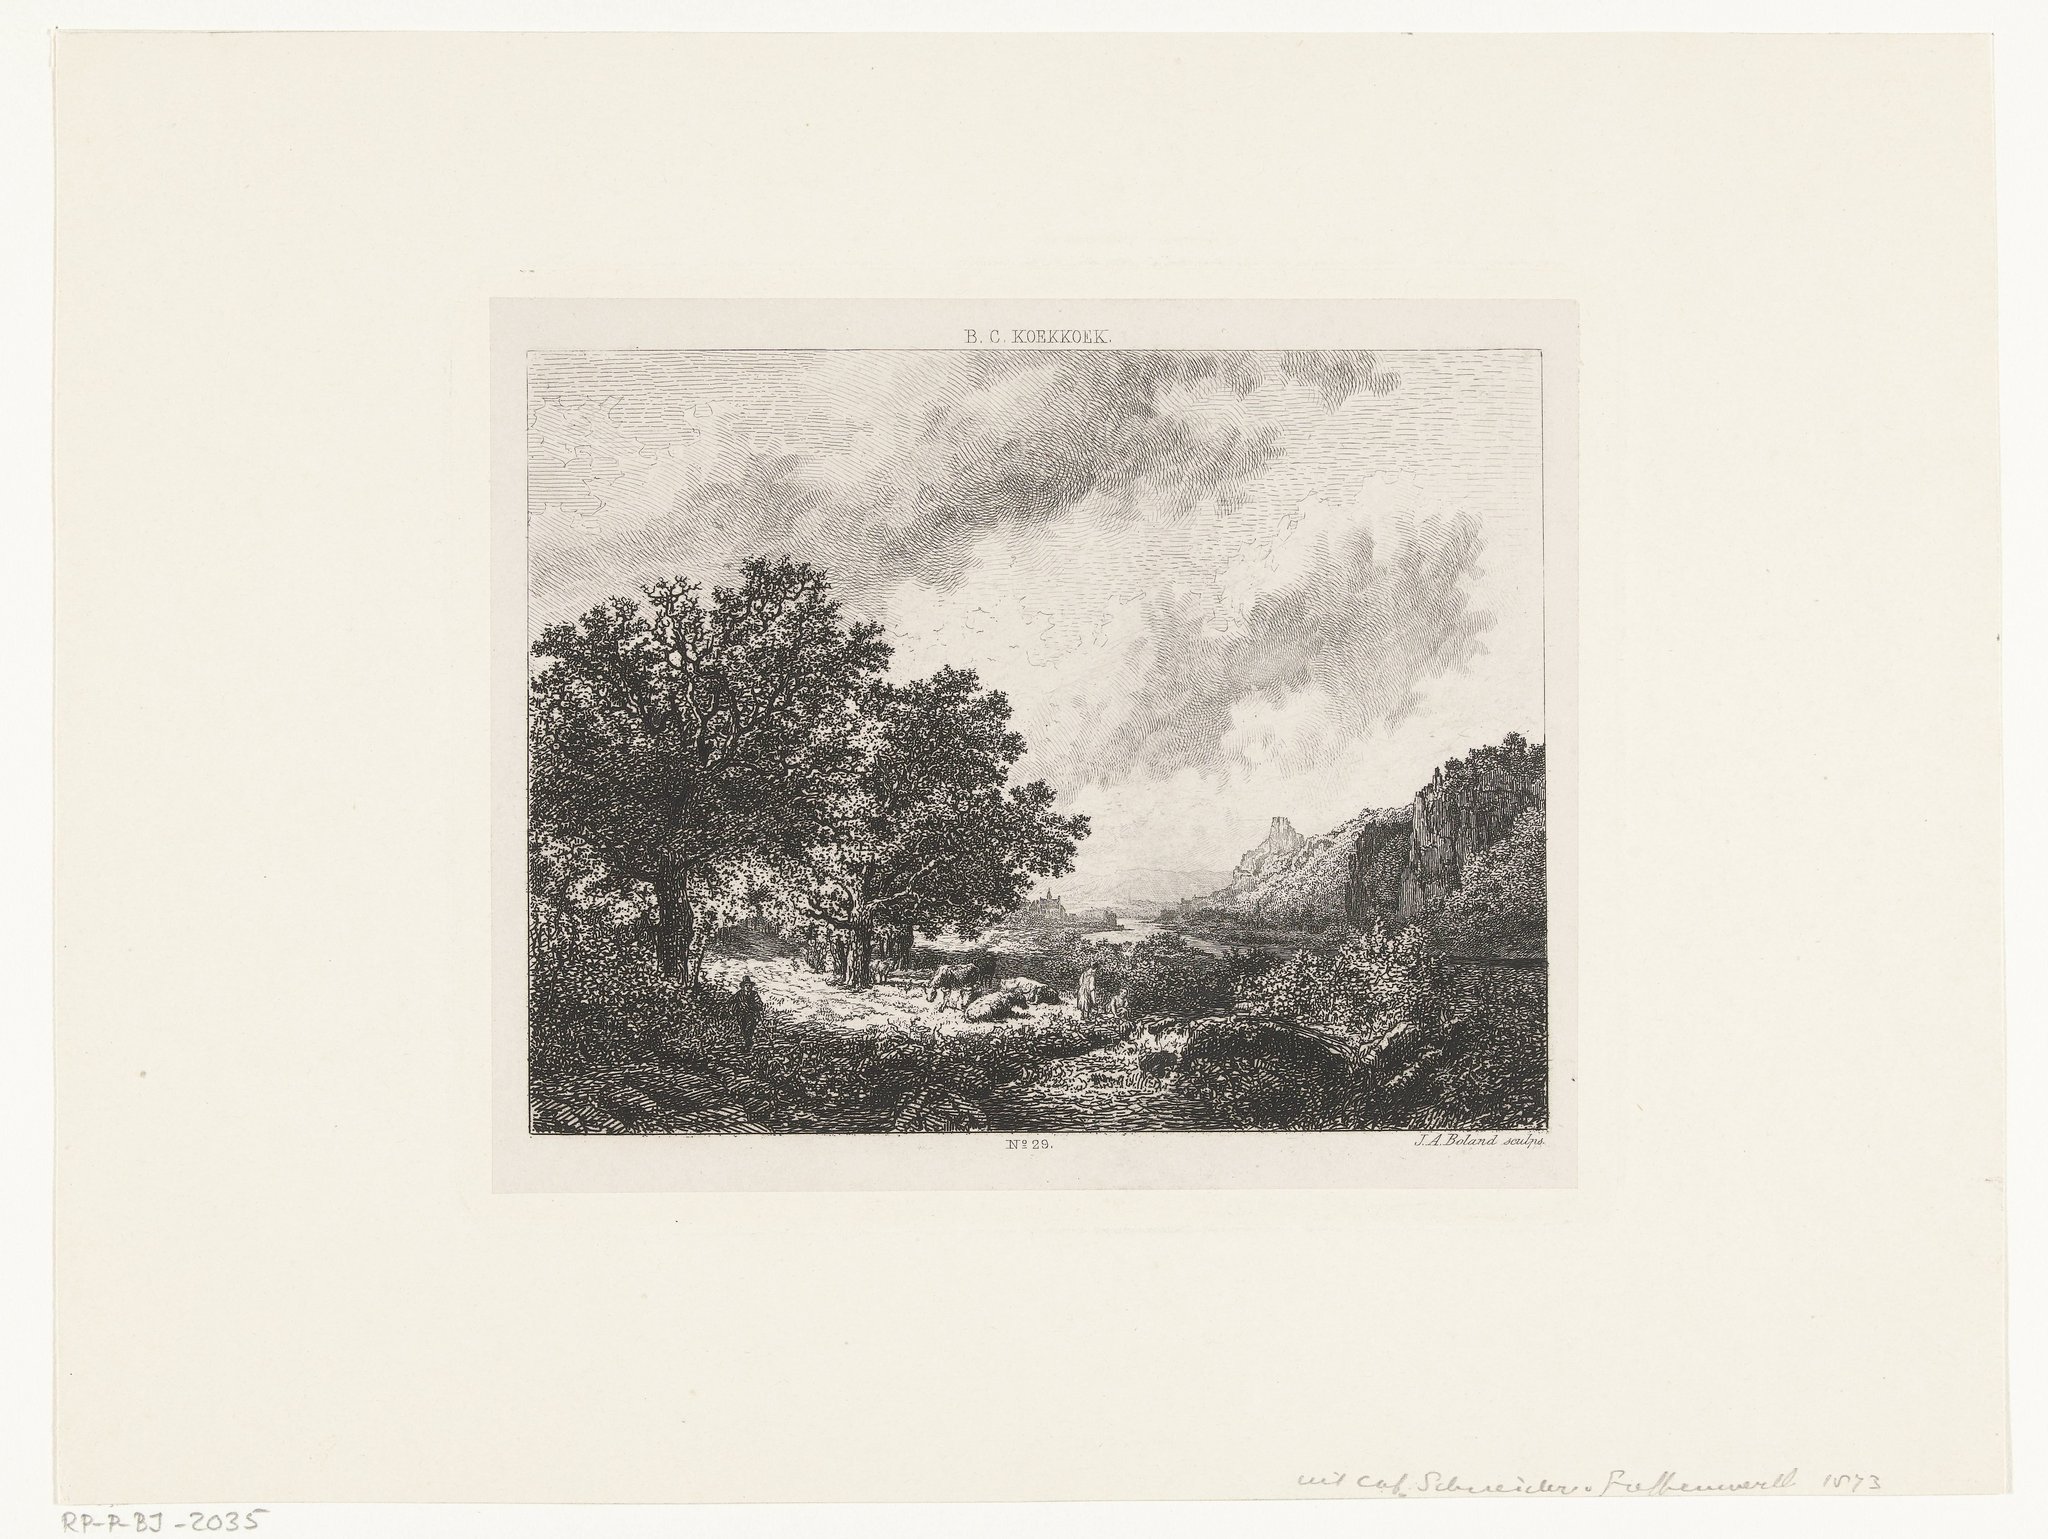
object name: print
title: Herders met vee bij een rivier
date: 1860-1900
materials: paper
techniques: etching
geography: amsterdam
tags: herding, herdsman, herdswoman, shepherd, shepherdess, cowherd, etc., pastorals, arcadian scenes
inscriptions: collector's mark: Lugt 2165